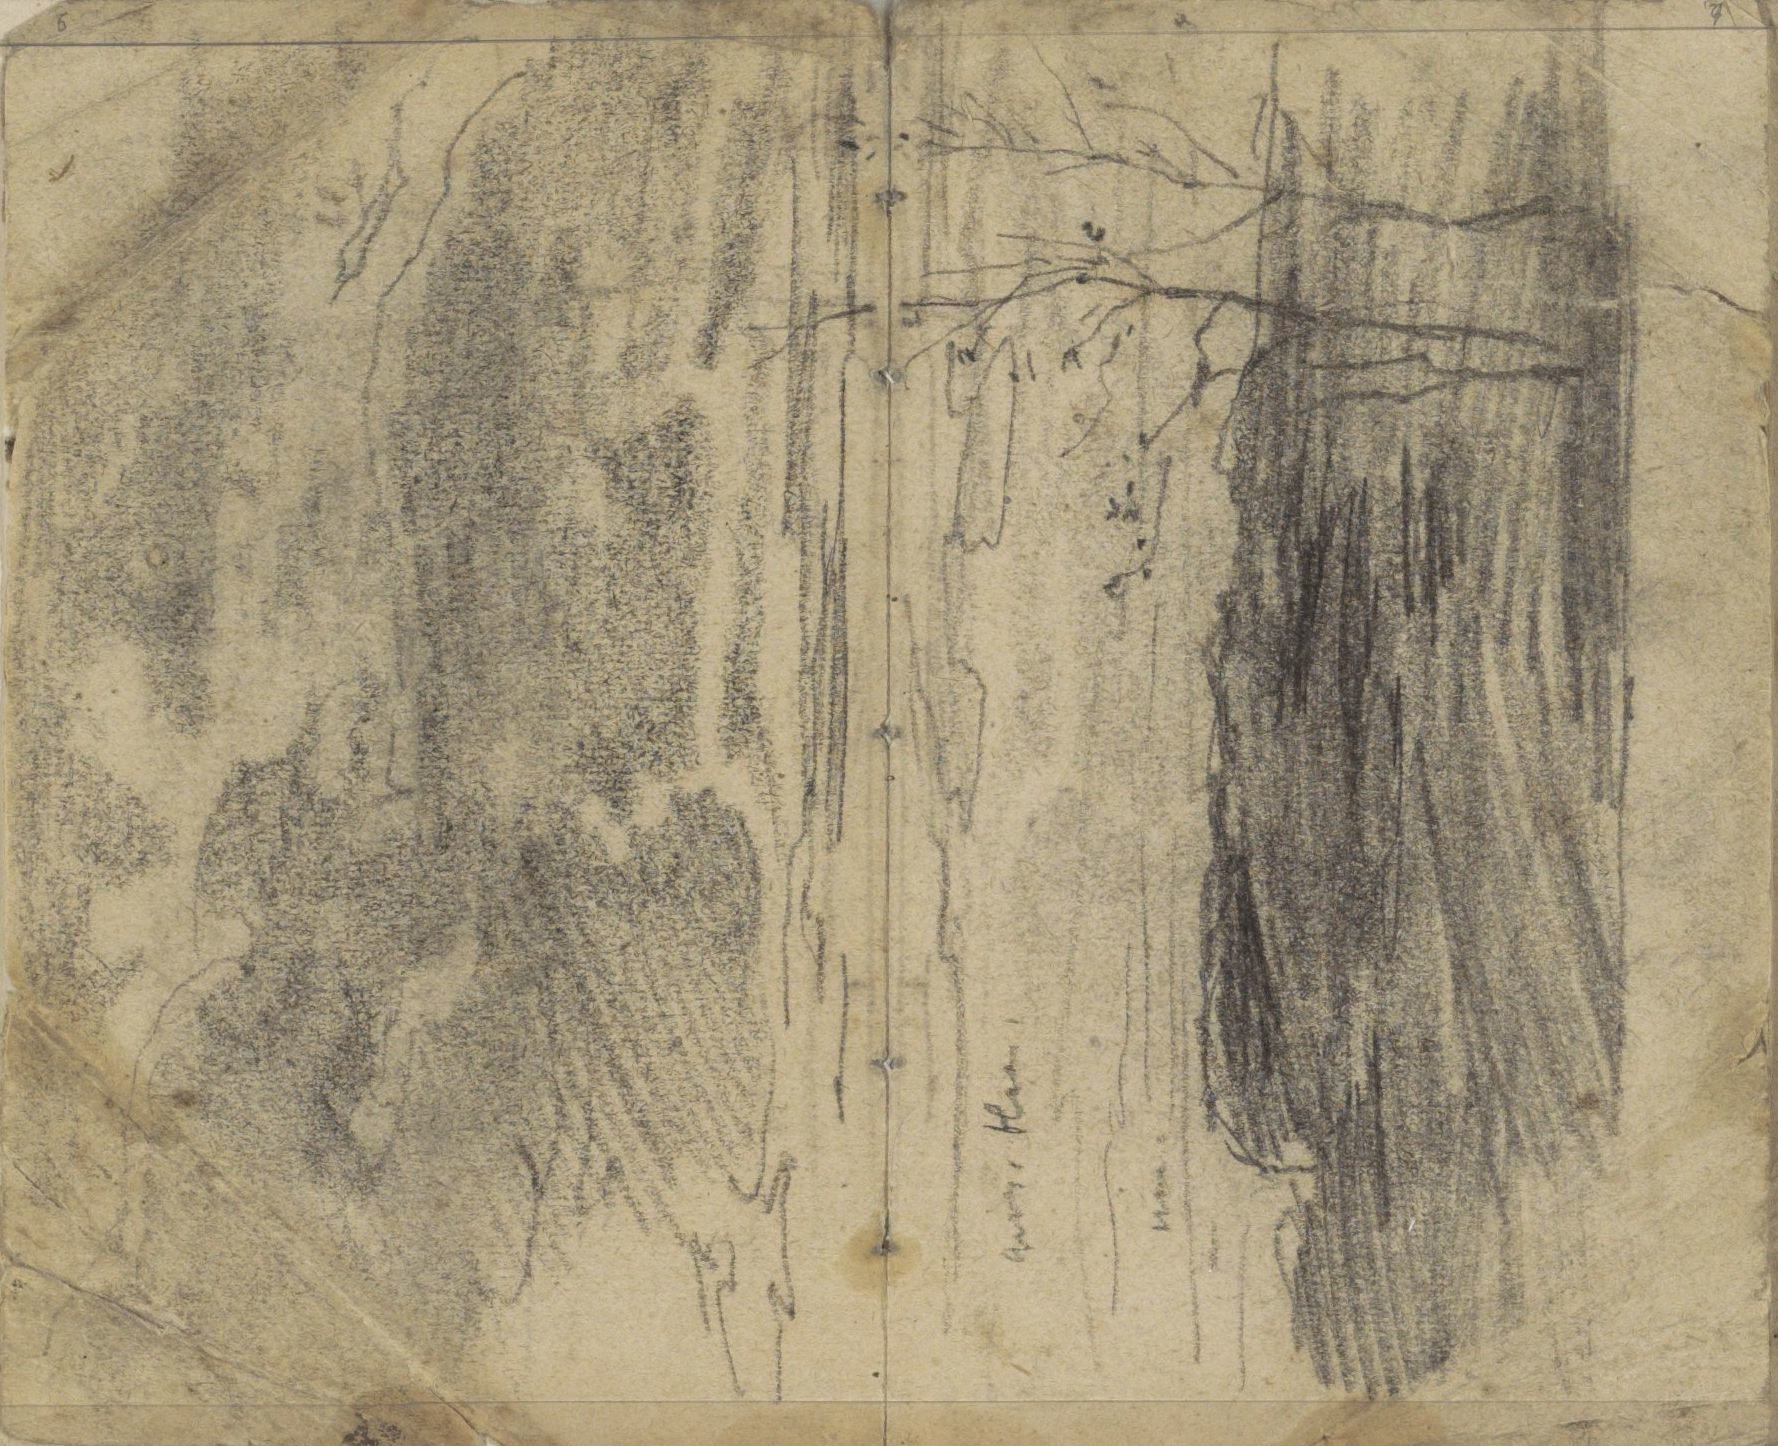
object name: sketchbook leaf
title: Landschap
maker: george hendrik breitner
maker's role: draughtsman, painter, print maker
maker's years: 1857-1923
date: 1881-1883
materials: chalk, paper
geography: south holland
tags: trees, landscapes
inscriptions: kleurnotitie, handgeschreven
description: Landschap. Pagina 6 en pagina 7 uit een schetsboek met 43 bladen.